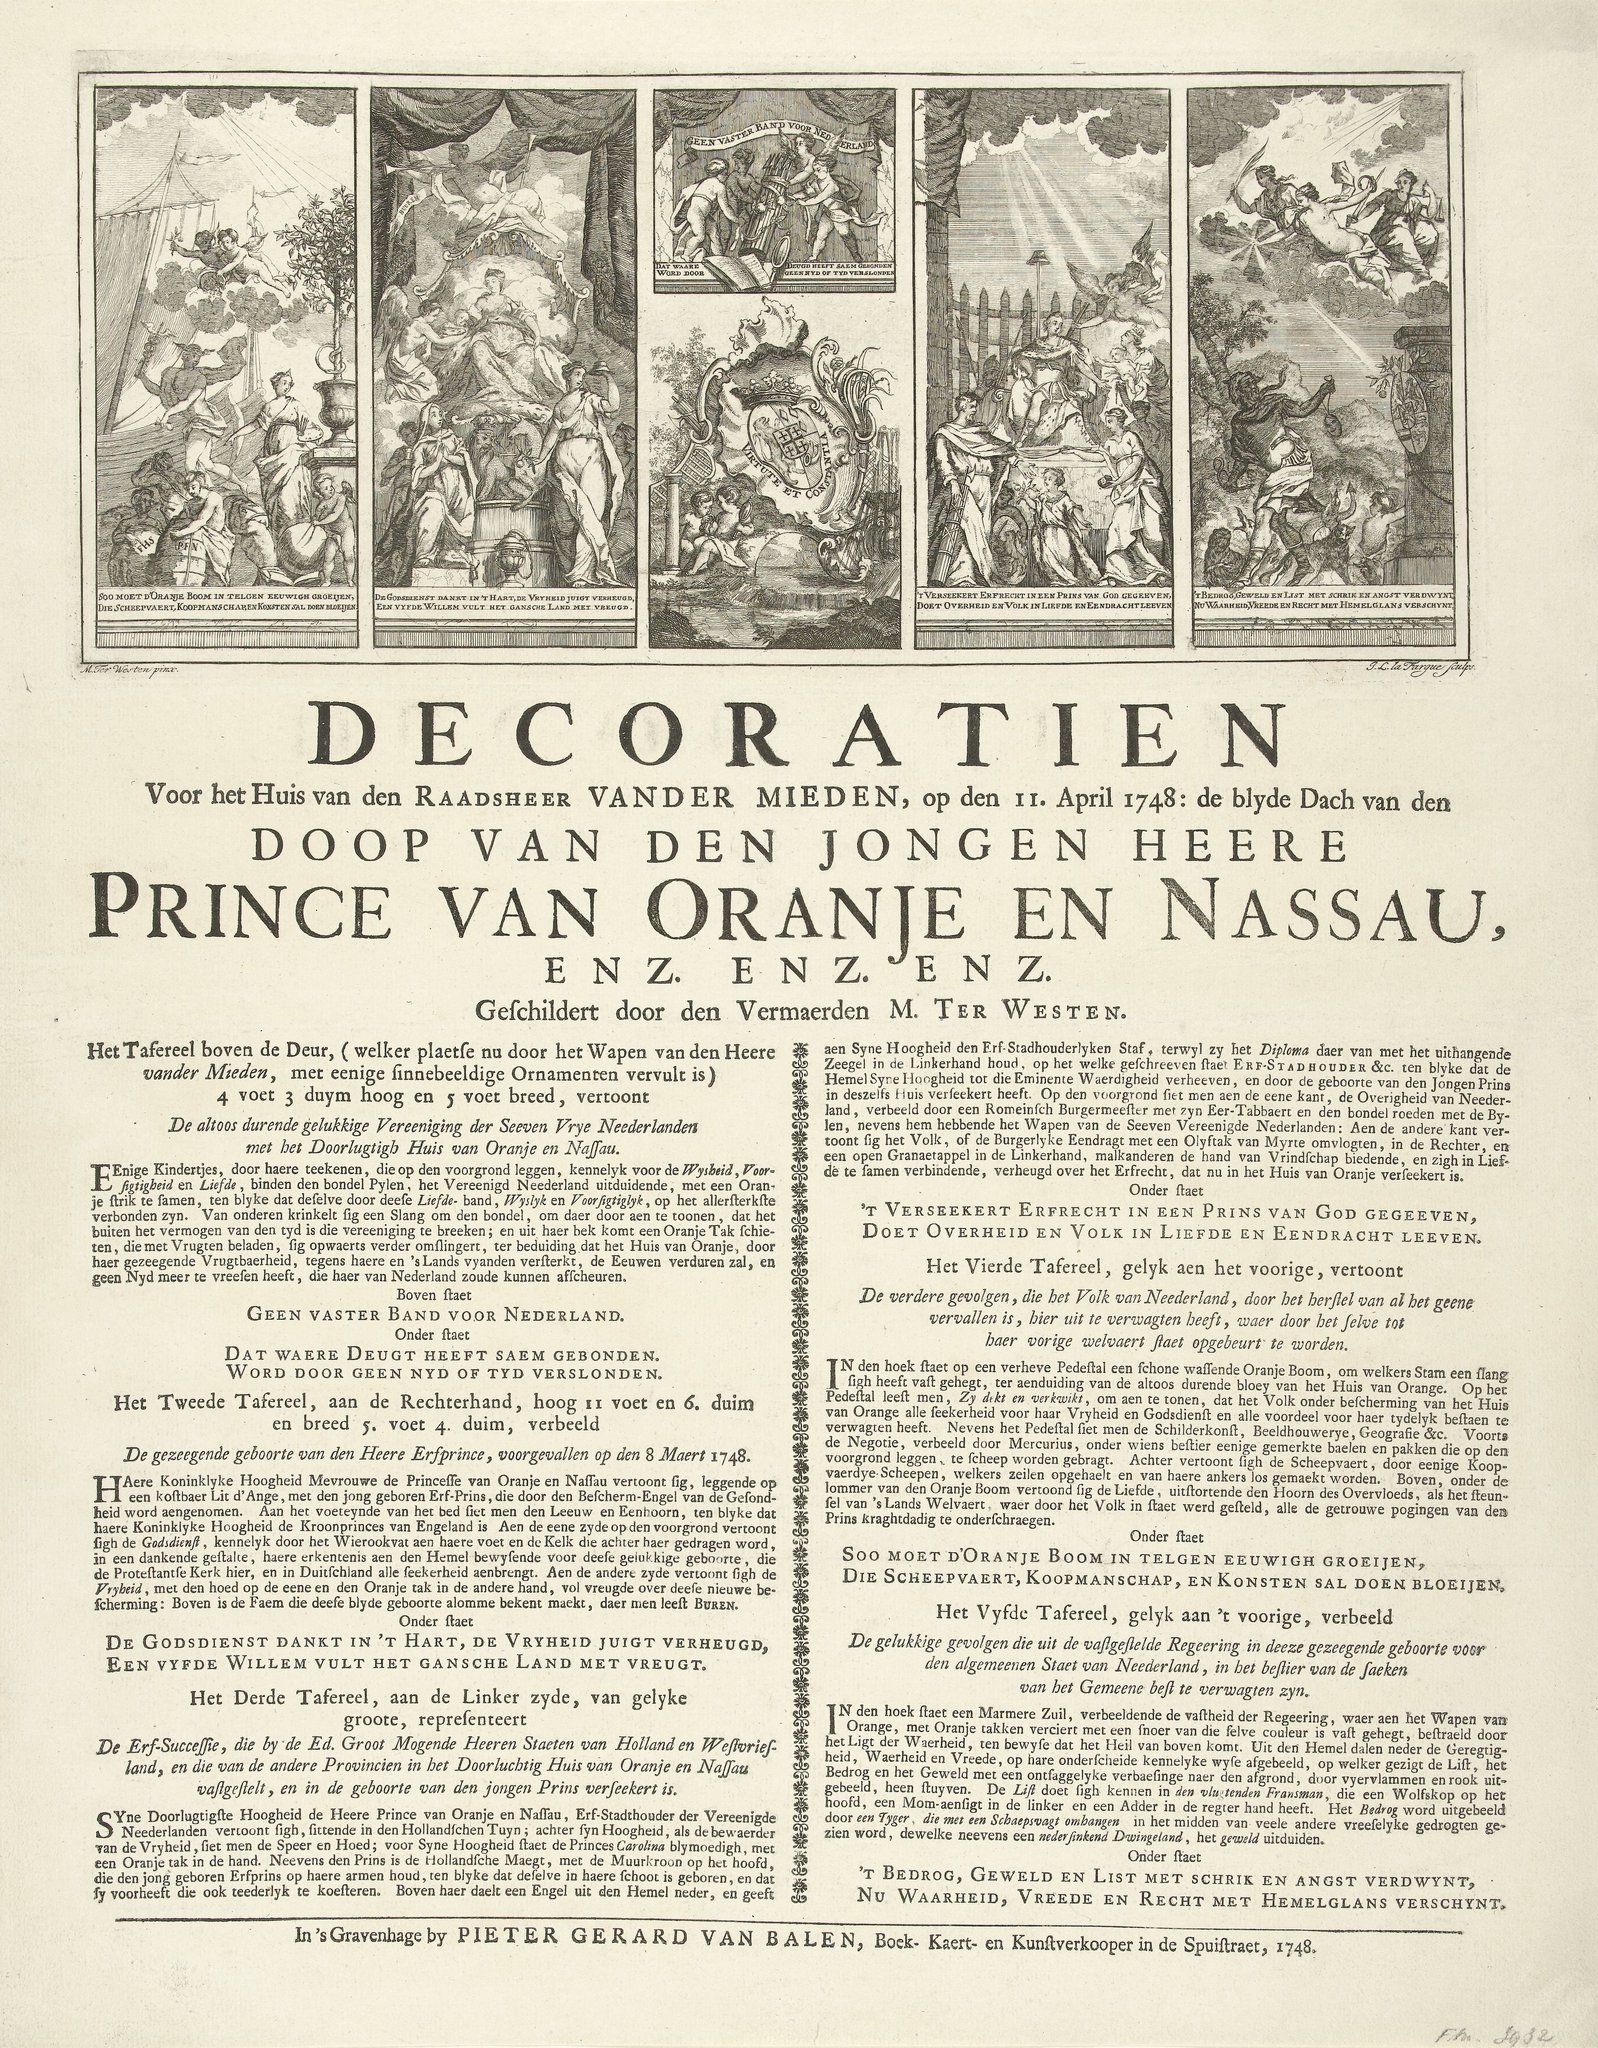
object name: print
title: Decoratiën voor het huis van de raadsheer Van der Mieden bij de doop van prins Willem V, 1748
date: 1748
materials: paper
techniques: etching, letterpress printing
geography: the hague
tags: the hague, william v (prince of orange), willem iv (prins van oranje-nassau)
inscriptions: collector's mark: Lugt 2228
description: Decoratiën opgesteld voor het huis van de raadsheer Van der Mieden in Den Haag ter gelegenheid van de doop van prins Willem V op 11 april 1748. Vier grote panelen (chassinetten) en twee kleinere panelen met geschilderde allegorische voorstellingen over het erfelijk bestuur van de prinsen Willem IV en Wilem V over de Verenigde Nederlanden. Op een klein paneel bestemd voor boven de deur staat het wapen van Van der Mieden.